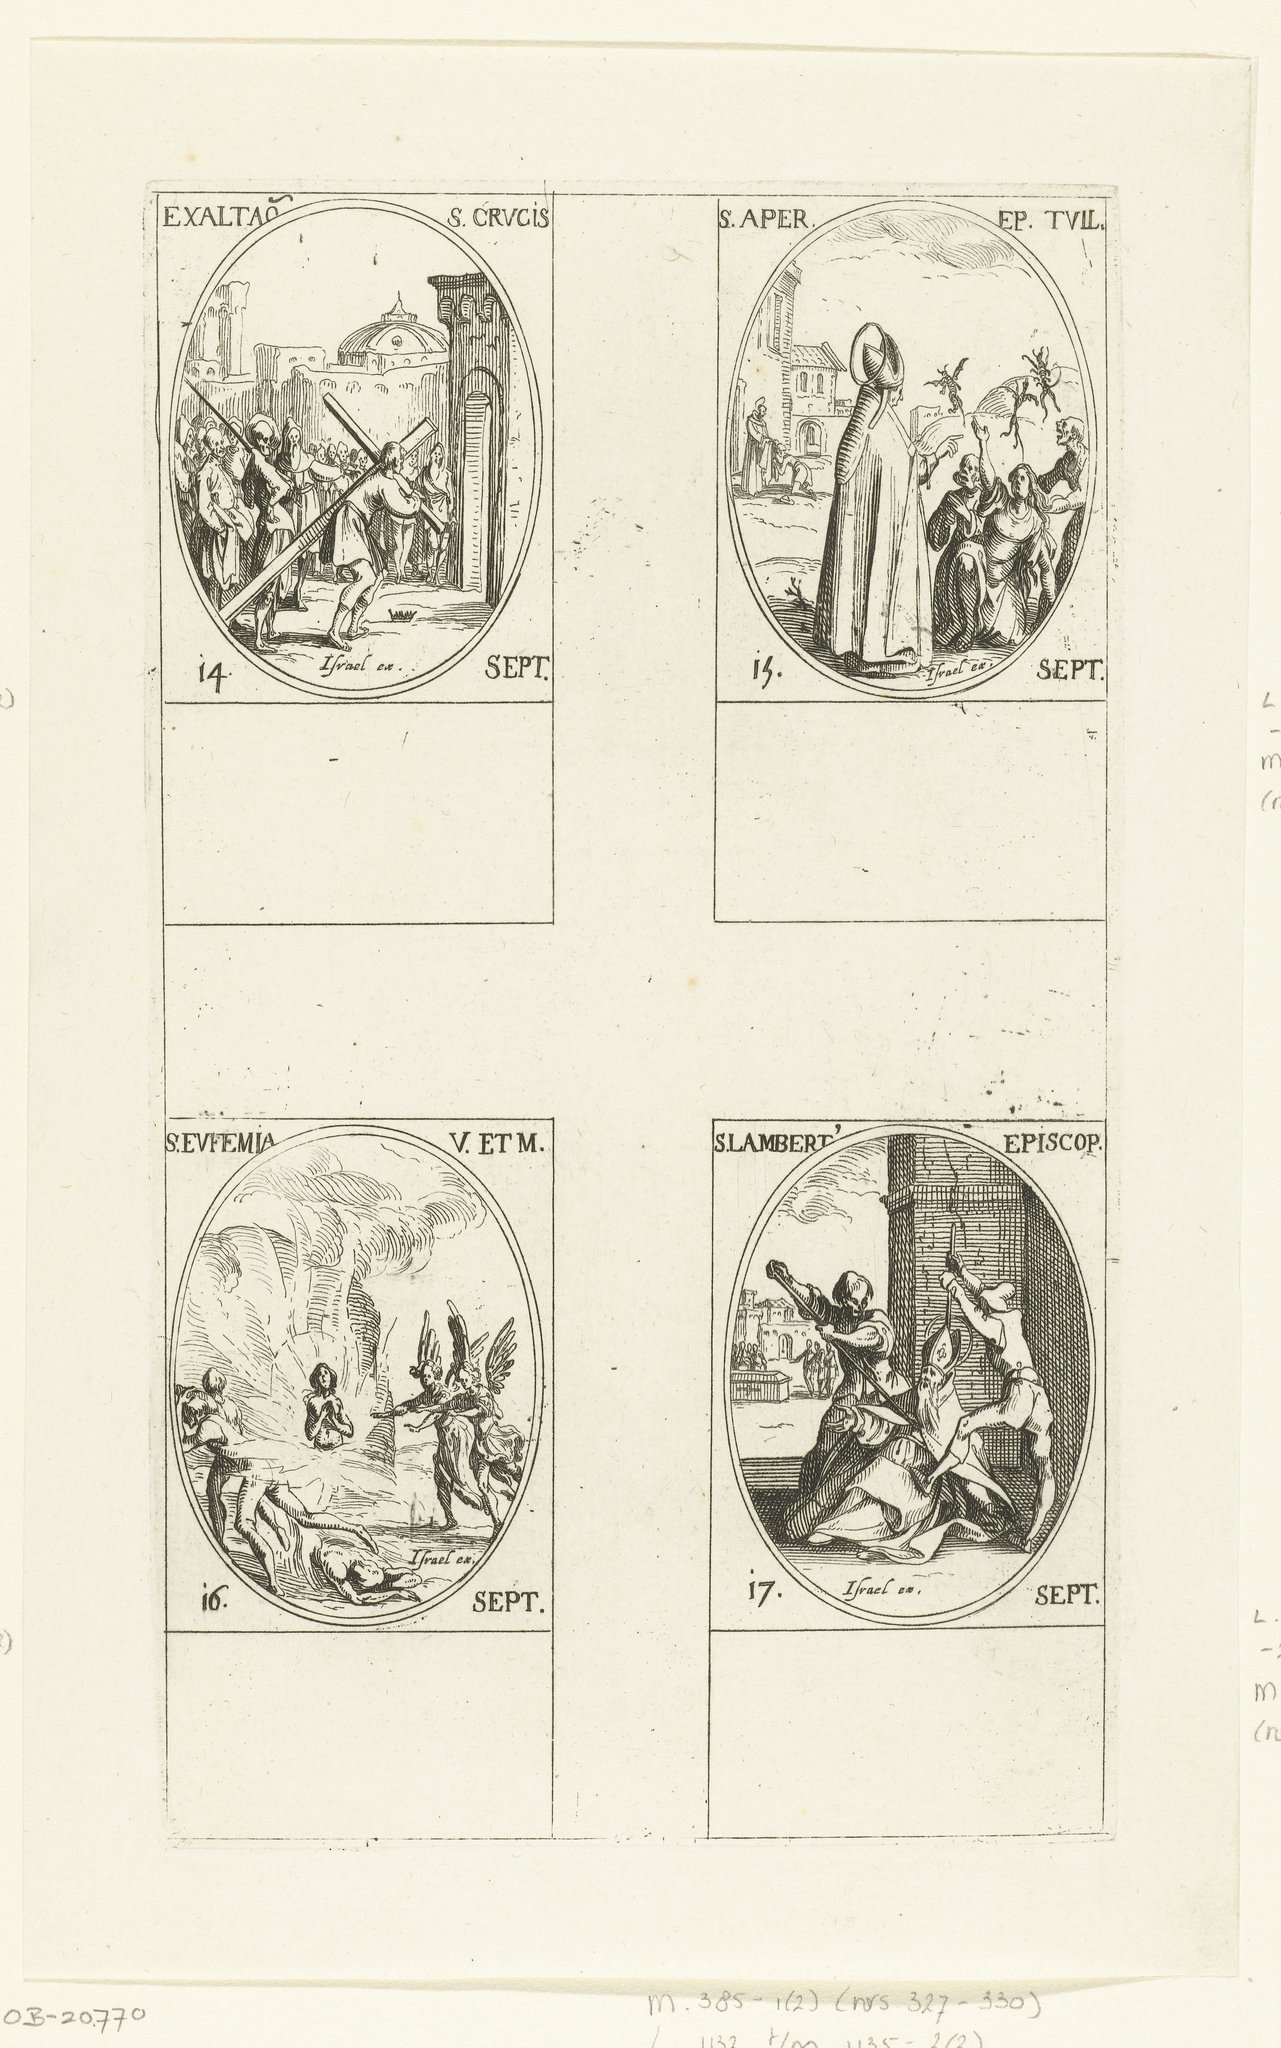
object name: print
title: Kruisdraging (Kruisverheffing), Heilige Aprus van Toul, Heilige Euphemia van Chalcedon, Heilige Lambertus van Maastricht (14-17 september)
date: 1632-1636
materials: paper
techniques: etching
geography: nancy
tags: st. lambert is killed by arrows, a lance or a sword, usually while kneeling in prayer, female saints (with name), male saints (with name), carrying of the cross: christ bearing the cross, alone or with the help of others (e.g. simon the cyrenian)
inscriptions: collector's mark: Lugt 240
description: Blad met vier ovale voorstellingen, elk met opschrift en datum in het Latijn: linksboven een man (Christus?) die een kruis naar een poort draagt in het bijzijn van een menigte mensen, rechtsboven de Heilige Aprus van Toul die duivels uitdrijft bij drie mensen, linksonder de Heilige Euphemia van Chalcedon in een oven vol vuur, rechtsonder de Heilige Lambertus van Maastricht die door twee mannen vermoord wordt. Deze prent is onderdeel van een serie prenten met voorstellingen van de heiligen en de christelijke feestdagen van het jaar. Er zijn steeds vier scènes van één plaat op één blad gedrukt. Inclusief bijbehorend titelblad en frontispice gaat het in totaal om 124 platen (490 voorstellingen). De drie platen met de laatste 12 scènes (de veranderlijke christelijke feestdagen) zijn in de derde staat versneden tot 12 kleine plaatjes, en met een apart titelblad uitgegeven.